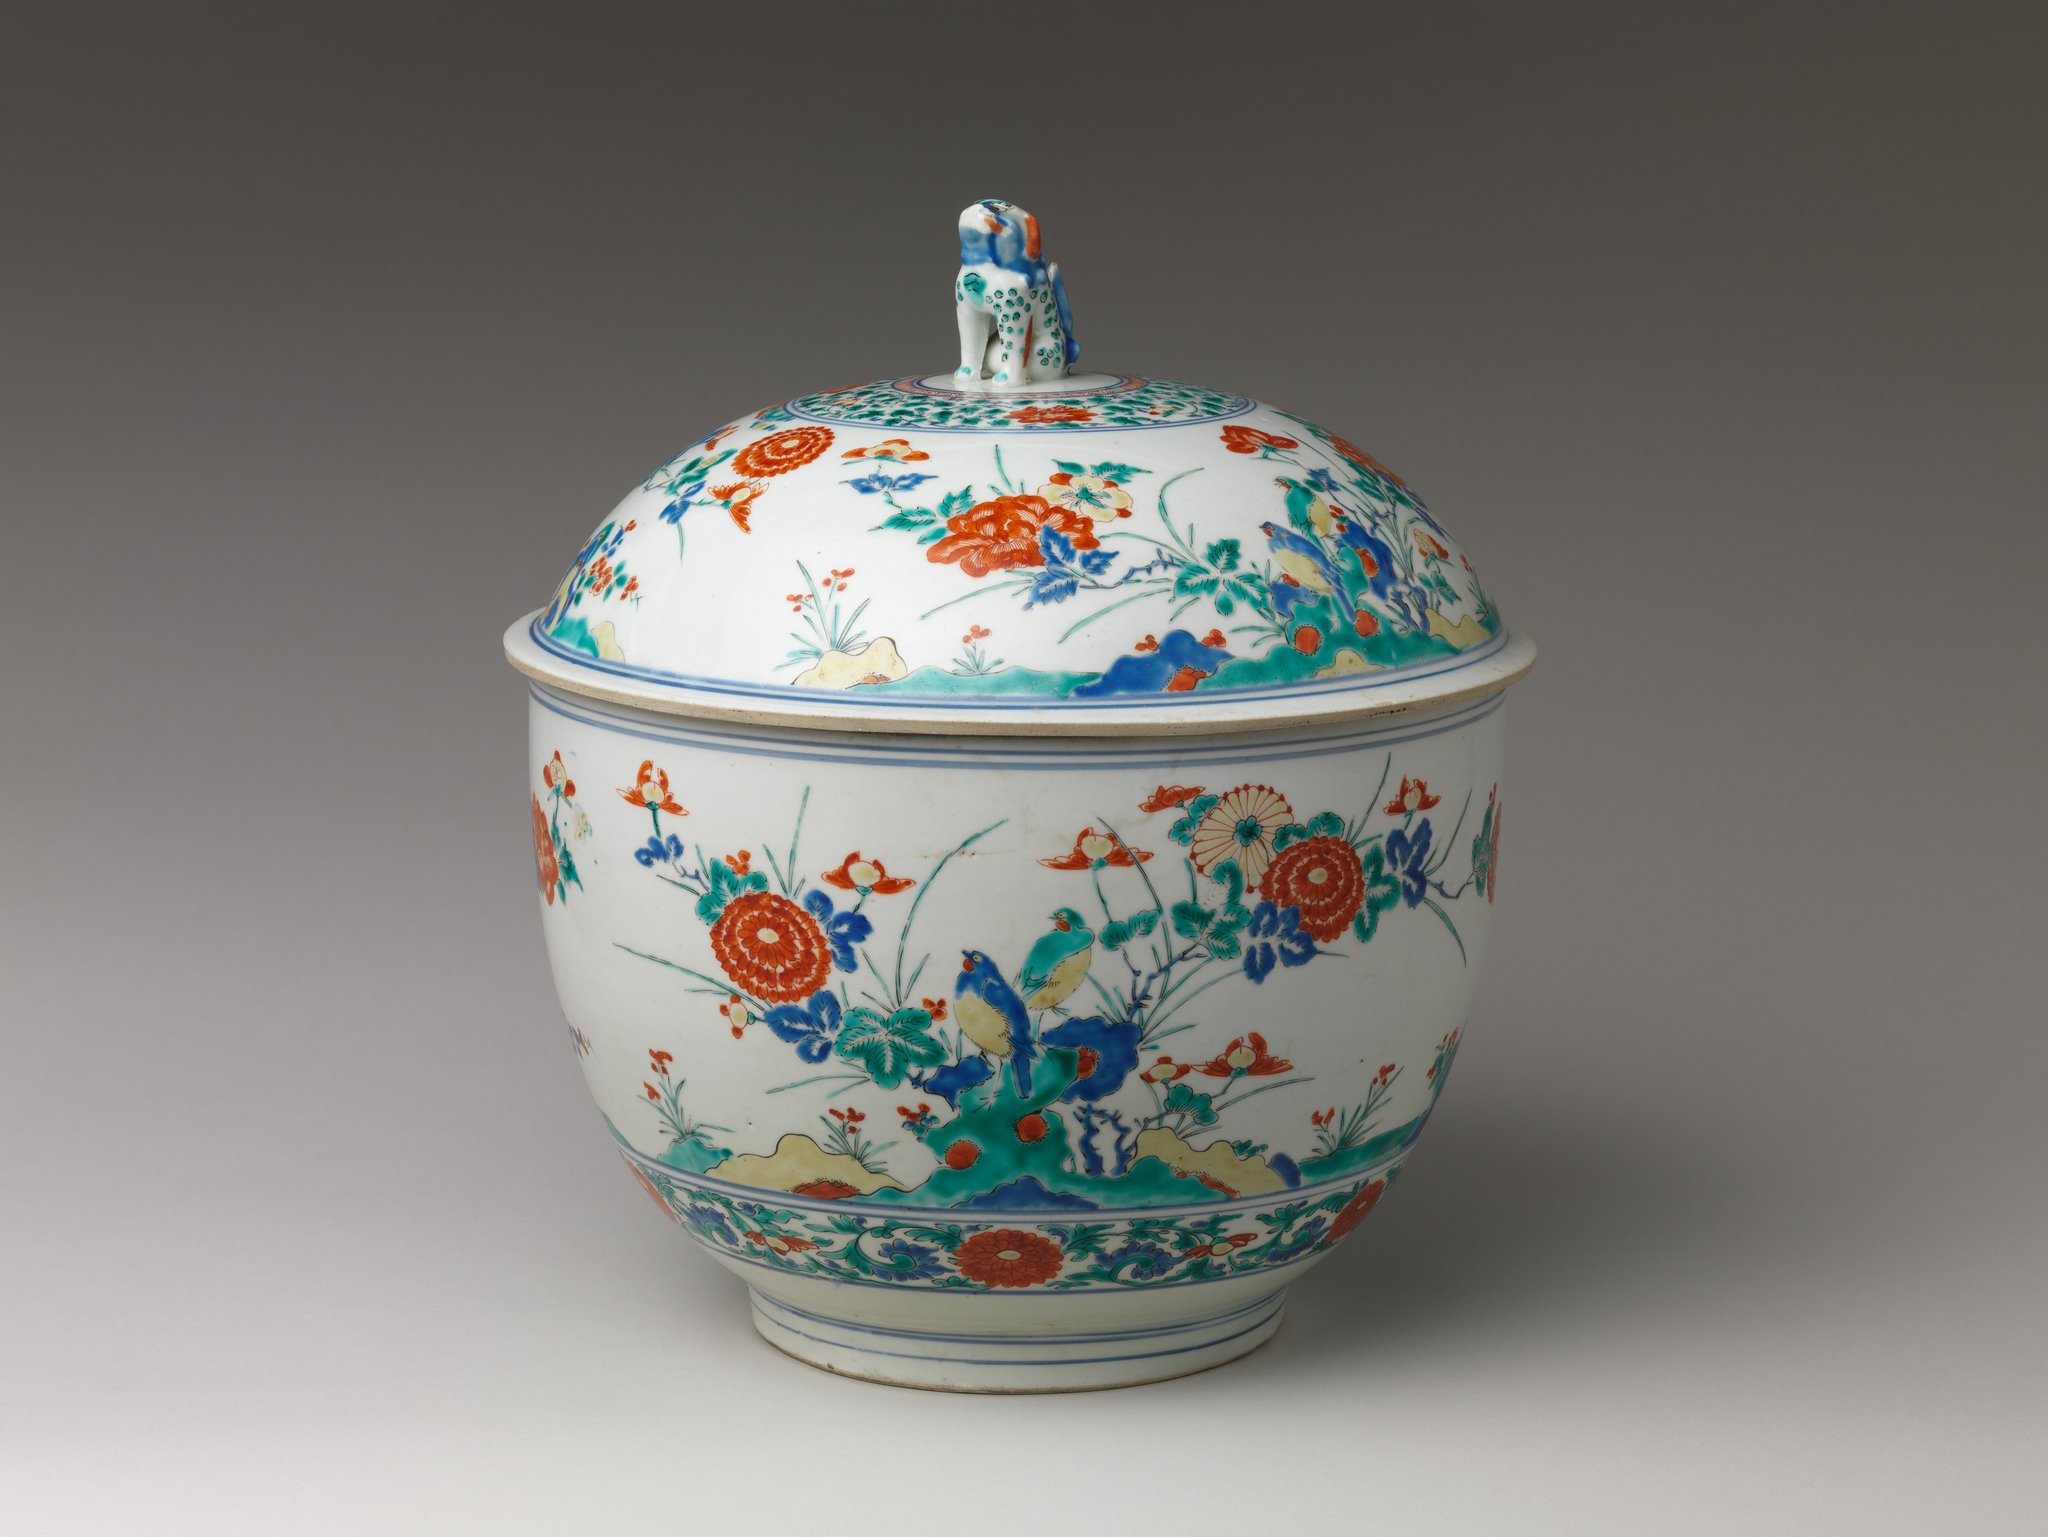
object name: bowl with lid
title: Tureen with rocks, flowers, and birds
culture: japanese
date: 1701-1800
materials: cobalt, enamel, glaze, porcelain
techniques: painting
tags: birds,flowers